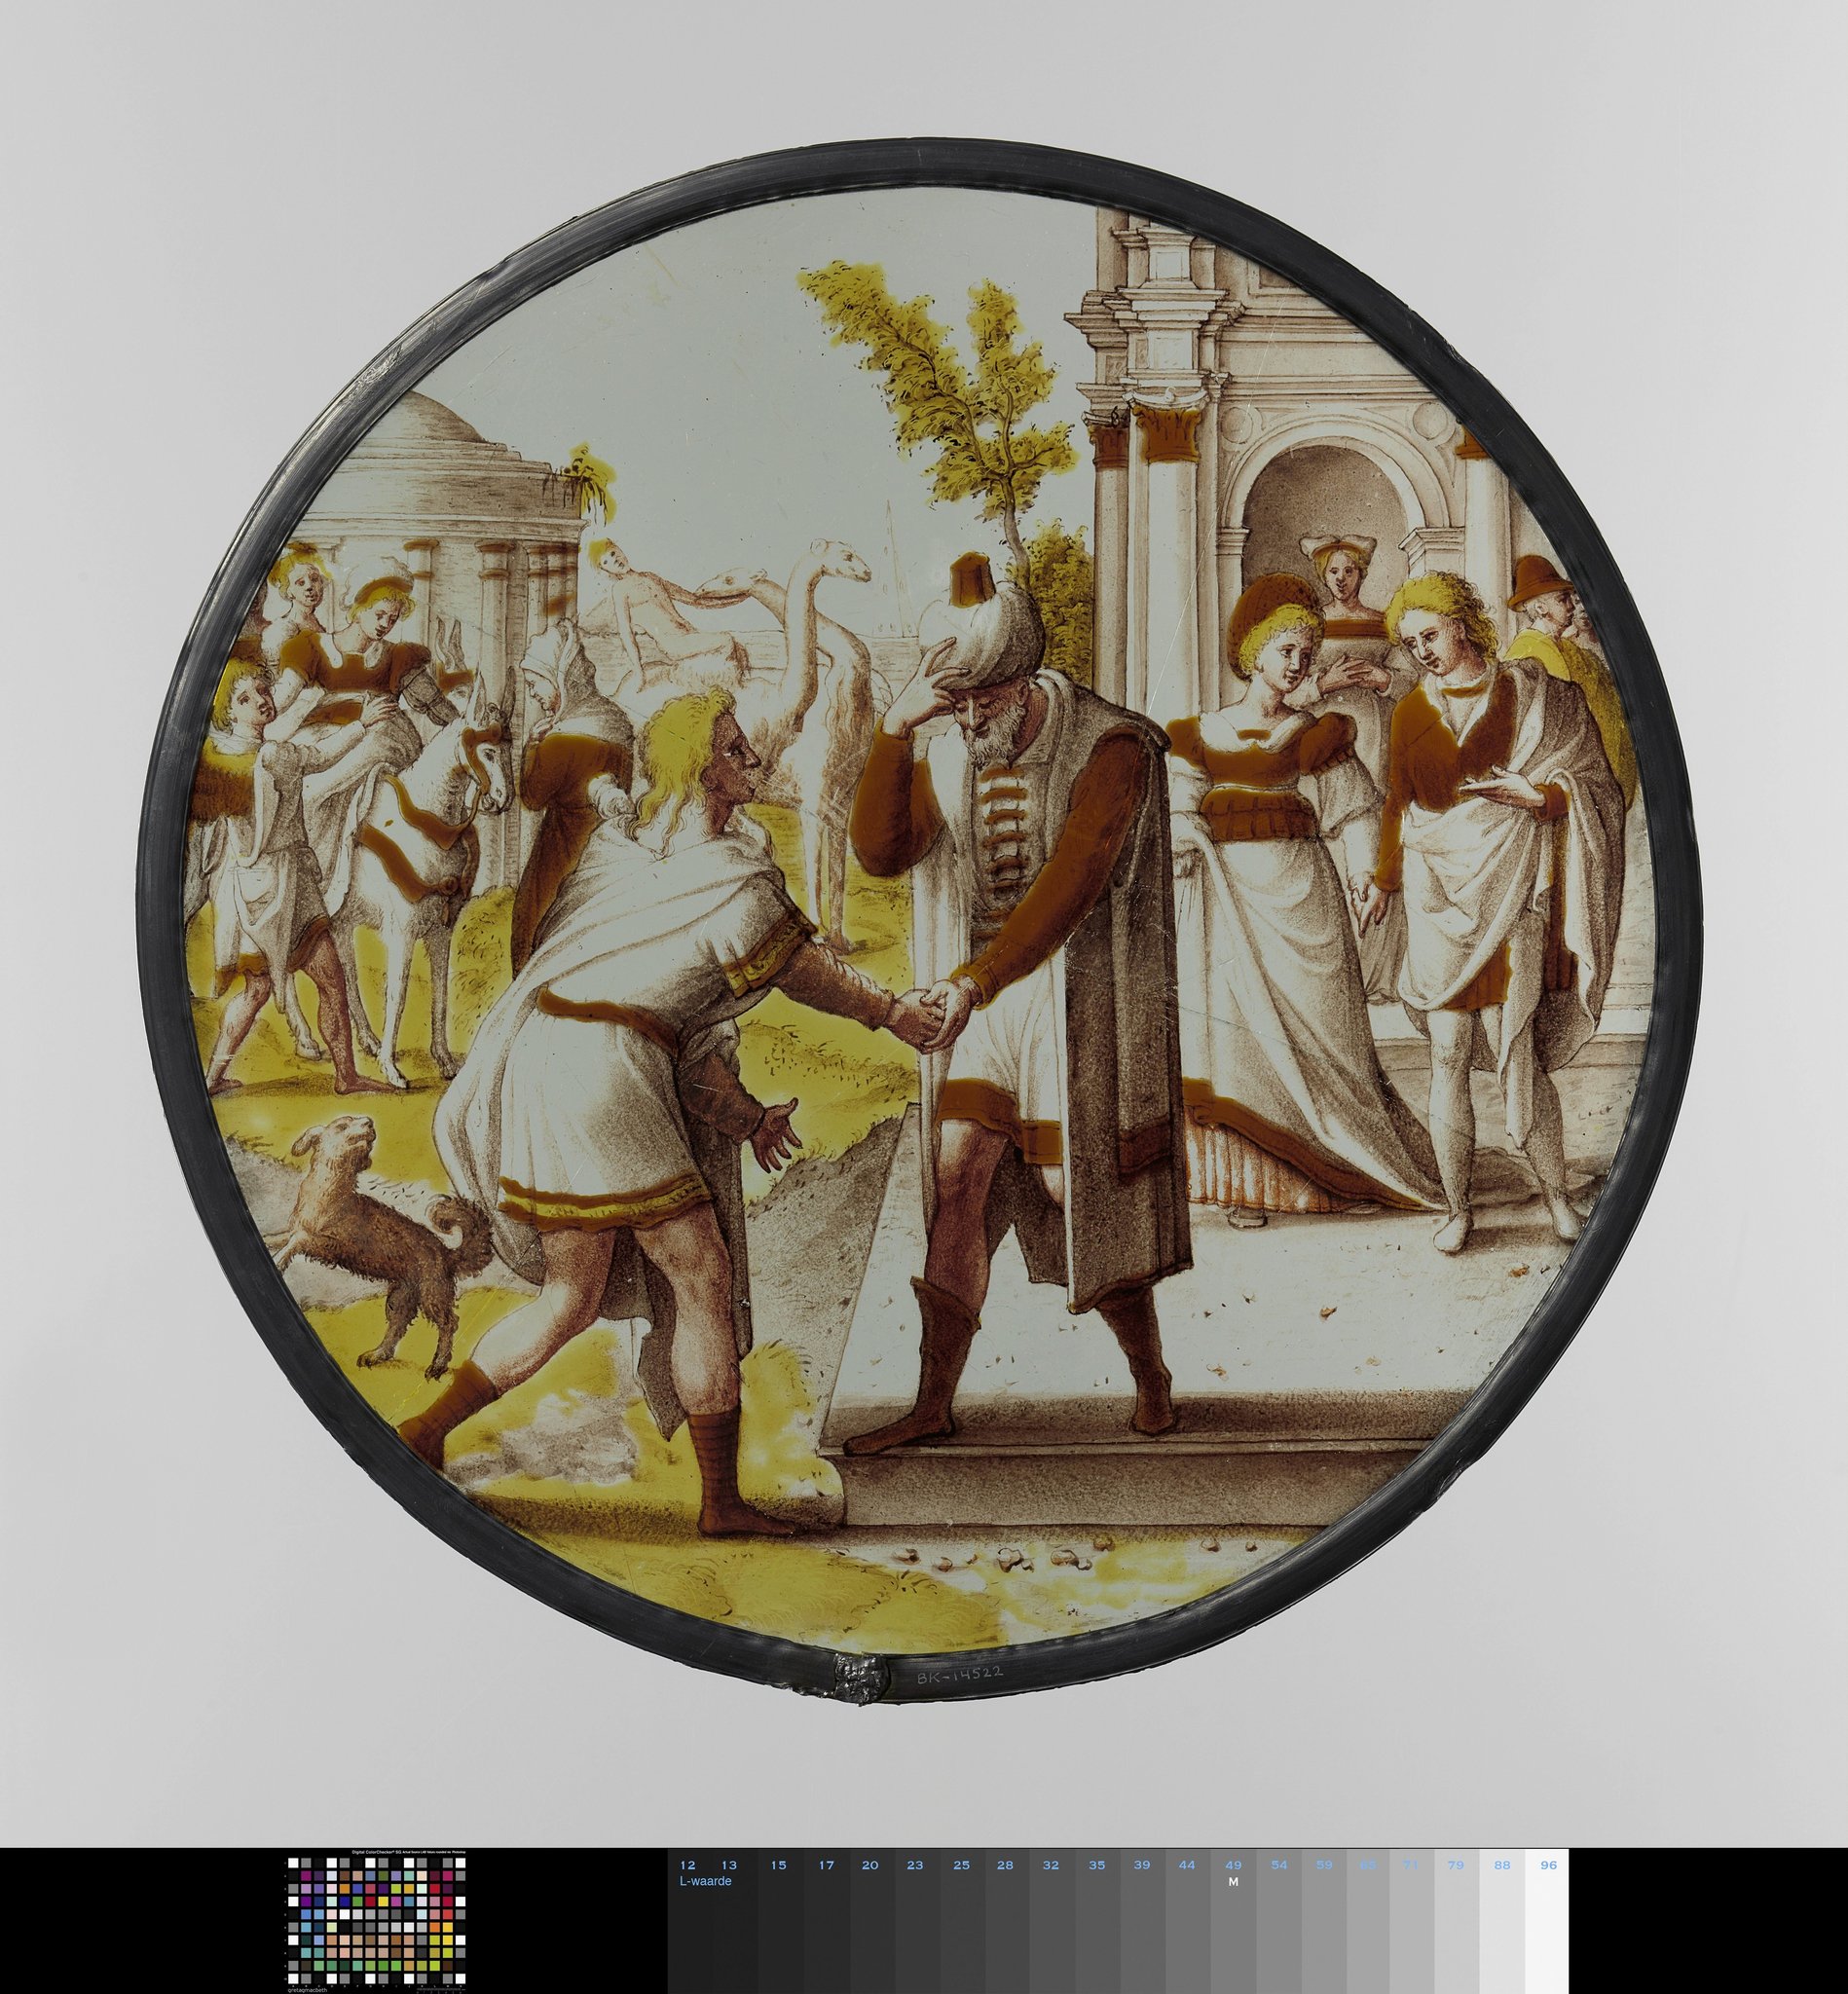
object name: light window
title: Ruit met de ontmoeting van Tobias met zijn blinde vader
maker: Anonymous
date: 1500-1600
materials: glass, lead, pigment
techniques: leading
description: The Story of Tobias. Stained glass. Southern Netherlands, c. 1525 - 1550.